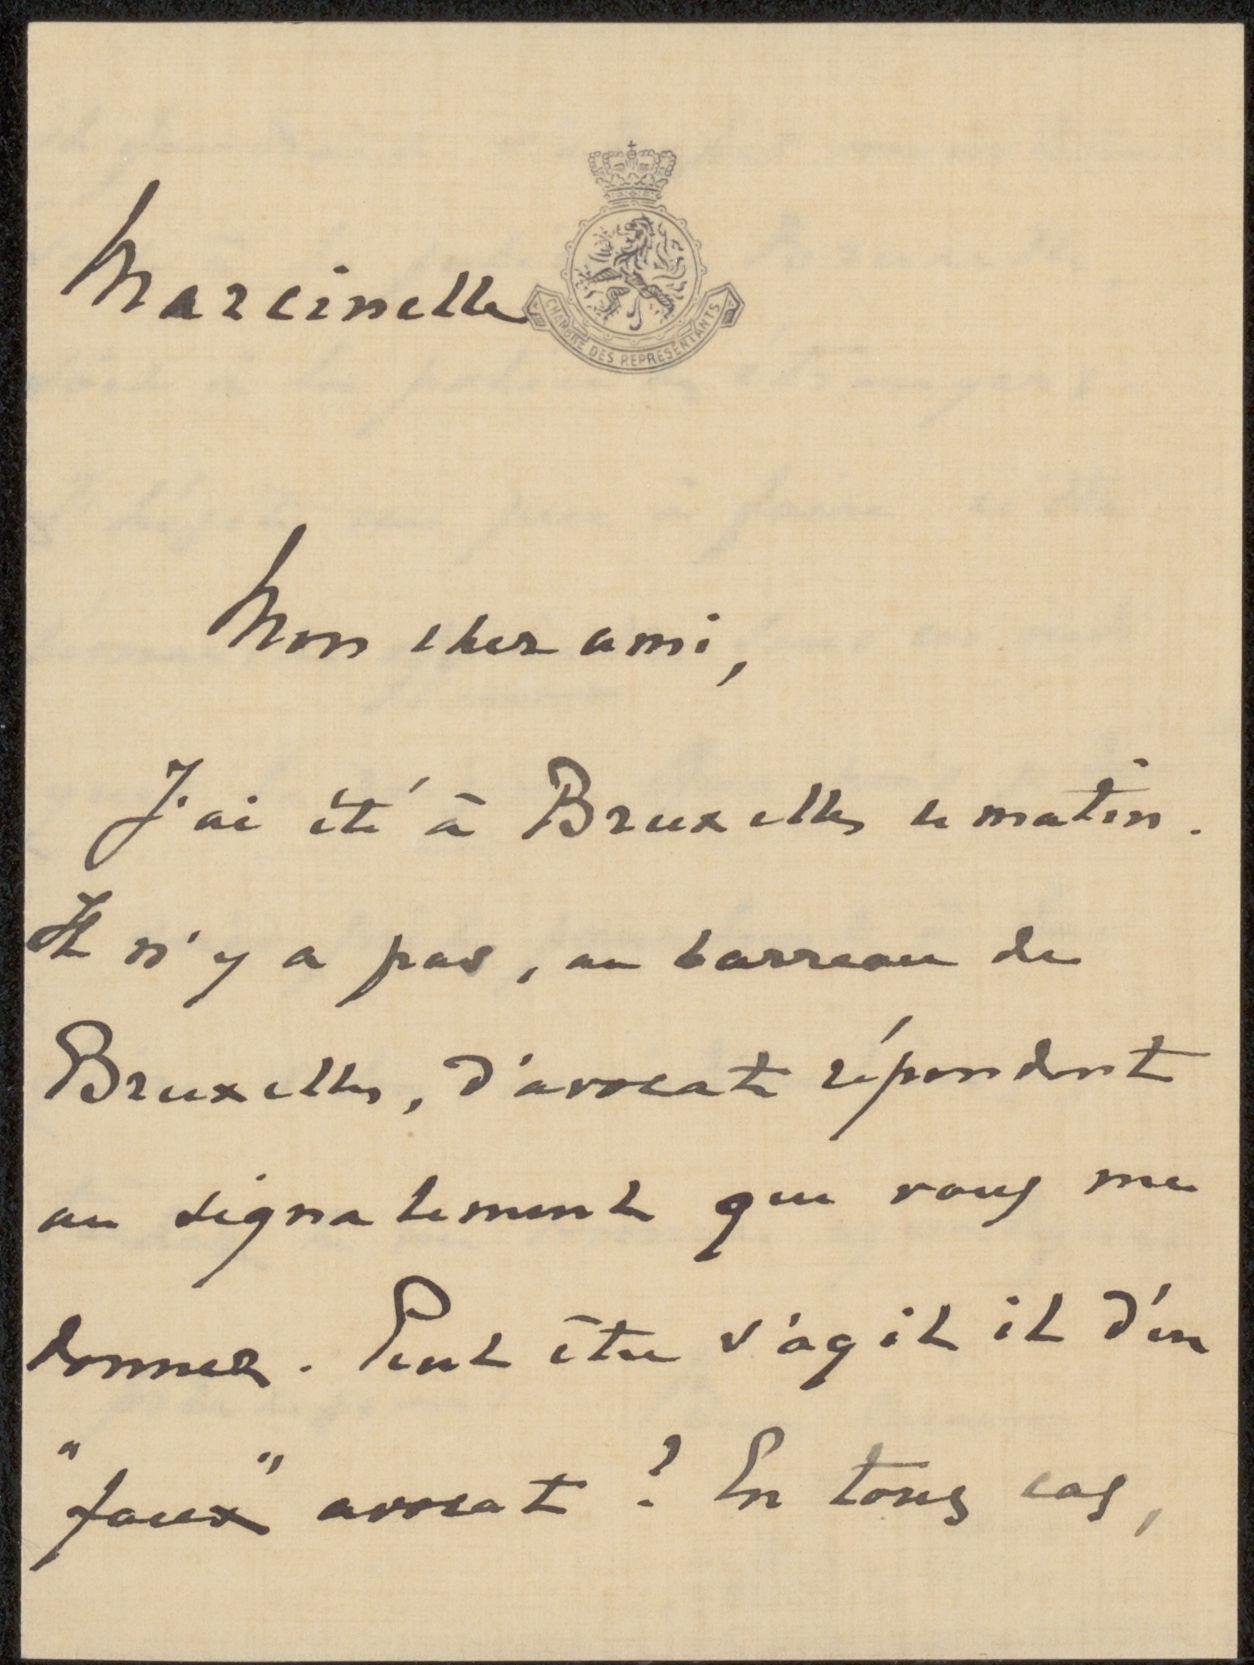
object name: letter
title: Brief aan Philip Zilcken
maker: jules destrée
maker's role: politician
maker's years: 1863-1936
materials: ink, paper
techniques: pen, writing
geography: marcinelle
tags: painter, draughtsman, philip zilcken, brussels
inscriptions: collector's mark: ‘RPK’